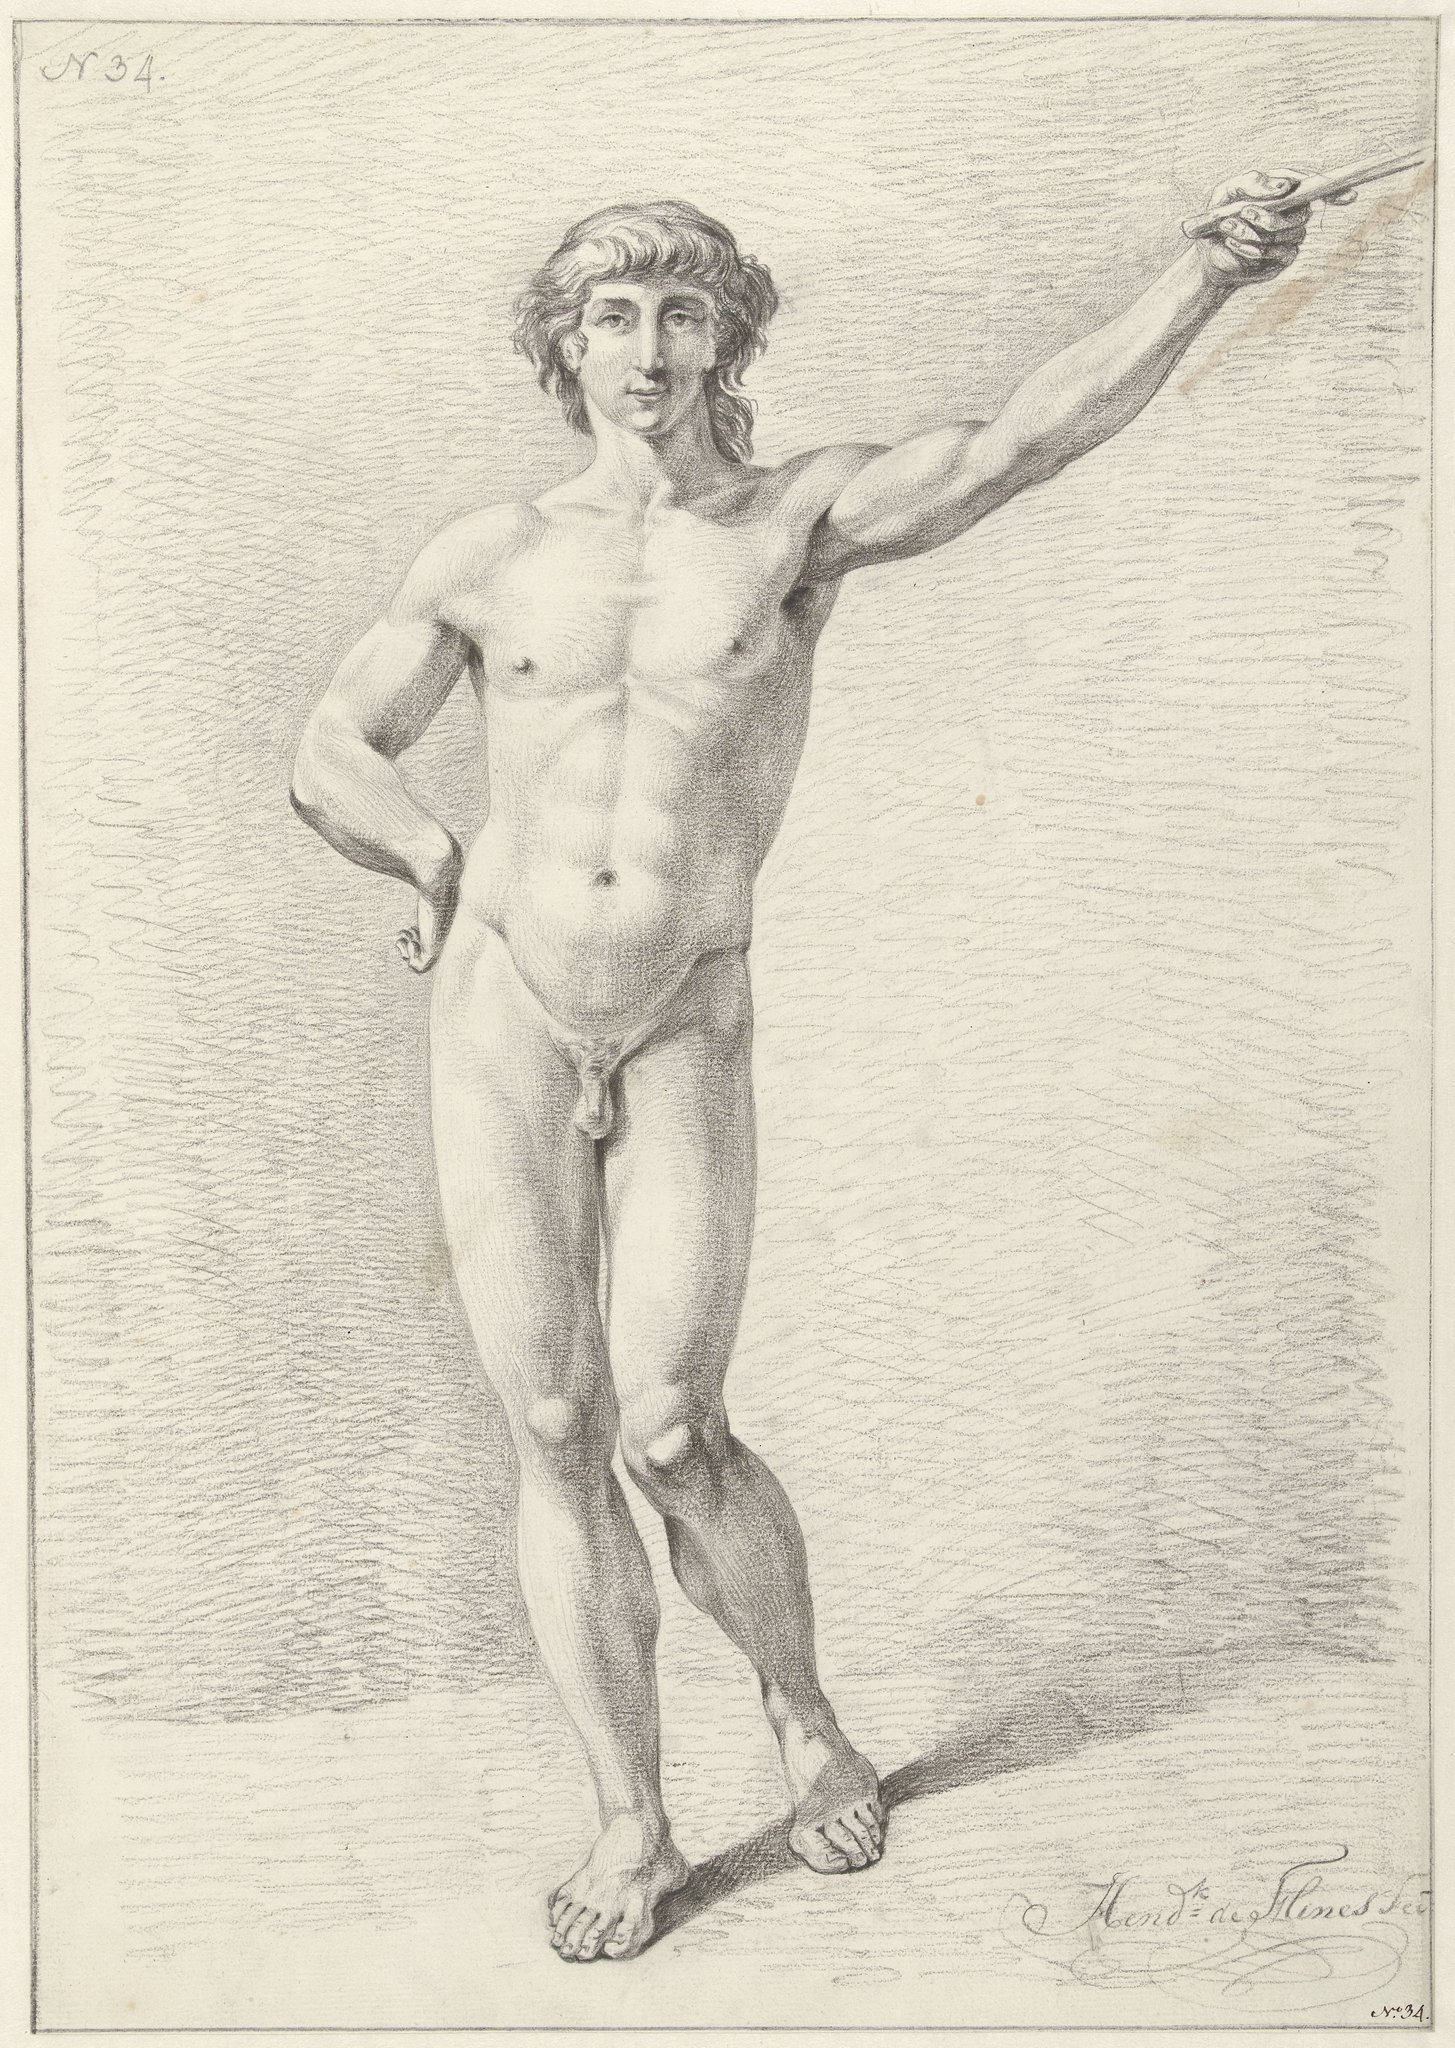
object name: drawing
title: Staand mannelijk naakt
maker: hendrik de flines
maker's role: draughtsman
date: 1784-1798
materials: chalk, paper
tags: standing figure